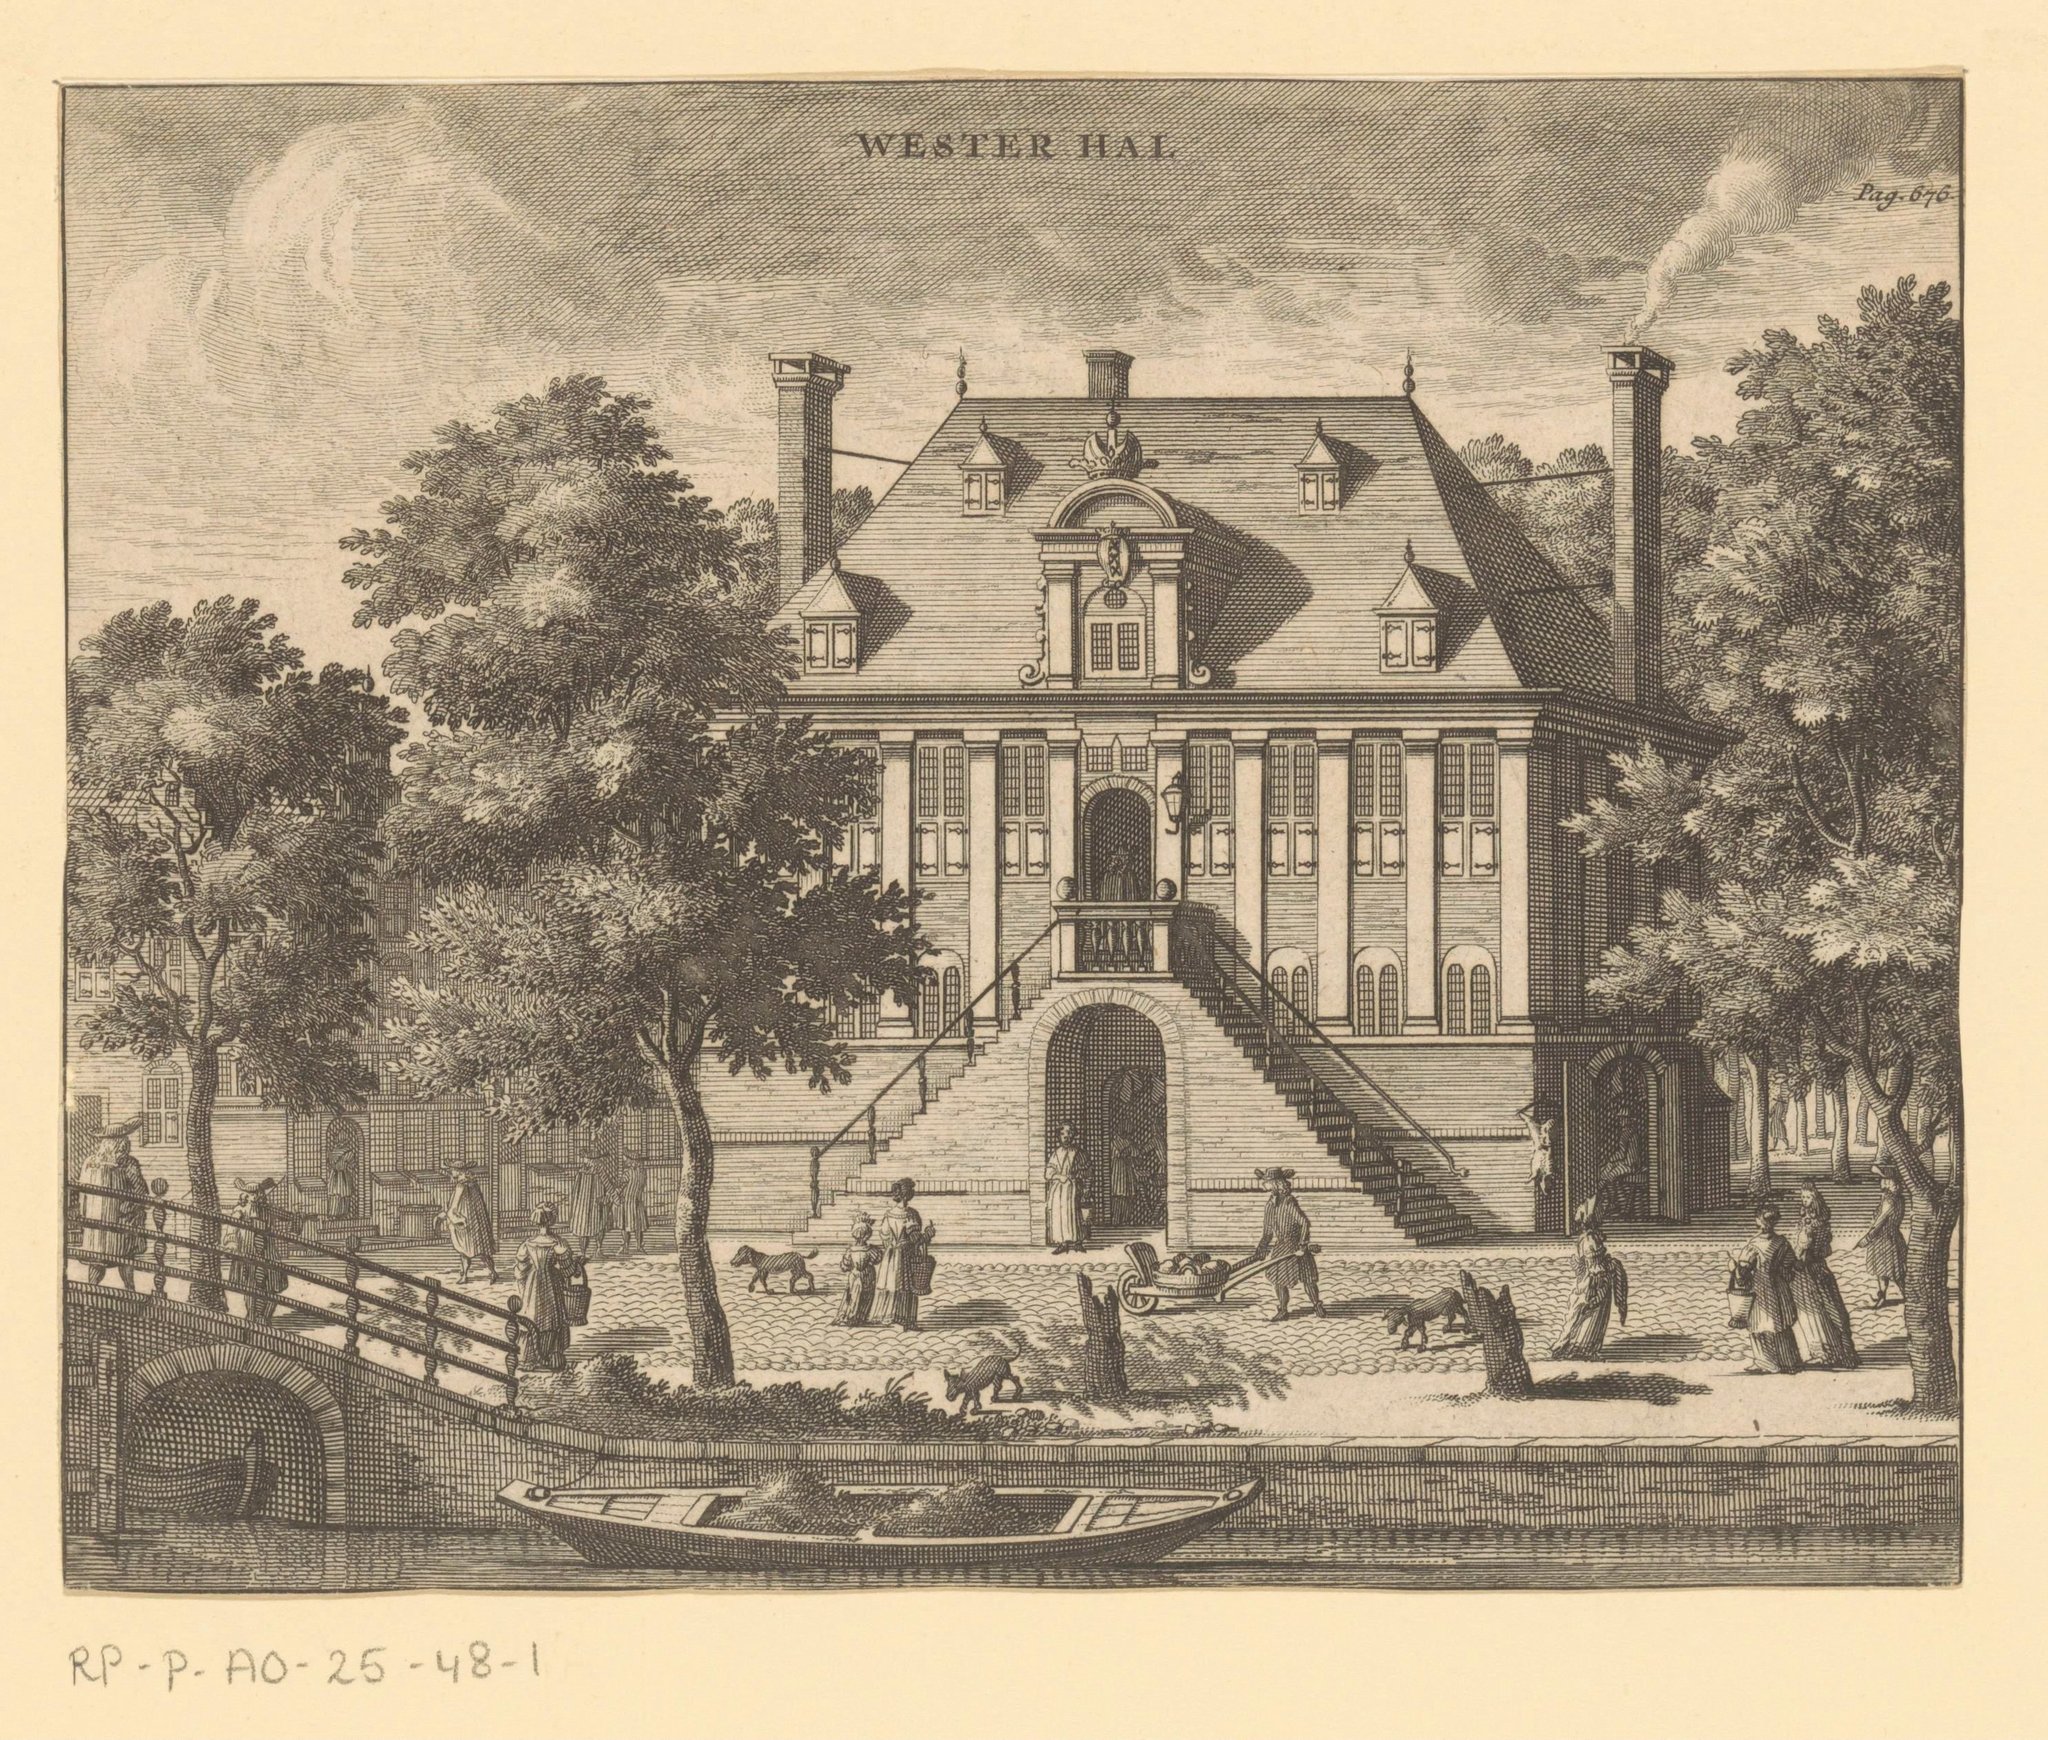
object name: book illustration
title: Gezicht op de Westerhal te Amsterdam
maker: Anonymous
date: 1726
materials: paper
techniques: engraving, etching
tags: bridge in city across river, canal, etc. (+ city(-scape) with figures, staffage), market, market-hall, street (+ city(-scape) with figures, staffage)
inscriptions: collector's mark: Lugt 195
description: Prent ook gebruikt in: Commelin, Caspar. Beschryvinge van Amsterdam, zynde een naukeurige verhandelinge van desselfs eerste oorspronk uyt (…). 2 delen. 2e druk. Amsterdam: Andries van Damme, Johannes Ratelband, weduwe A. van Aaltwyk en Hermanus Uytwerf, 1726. In tegenstelling tot de meeste prenten uit deze publicatie komt deze prent niet in huidige of eerdere staat voor in de uitgaves van 1693 en 1694. Voor latere staat van prent (nummering rechtsboven zichtbaar verwijderd) zie RP-P-AO-25-48-2.